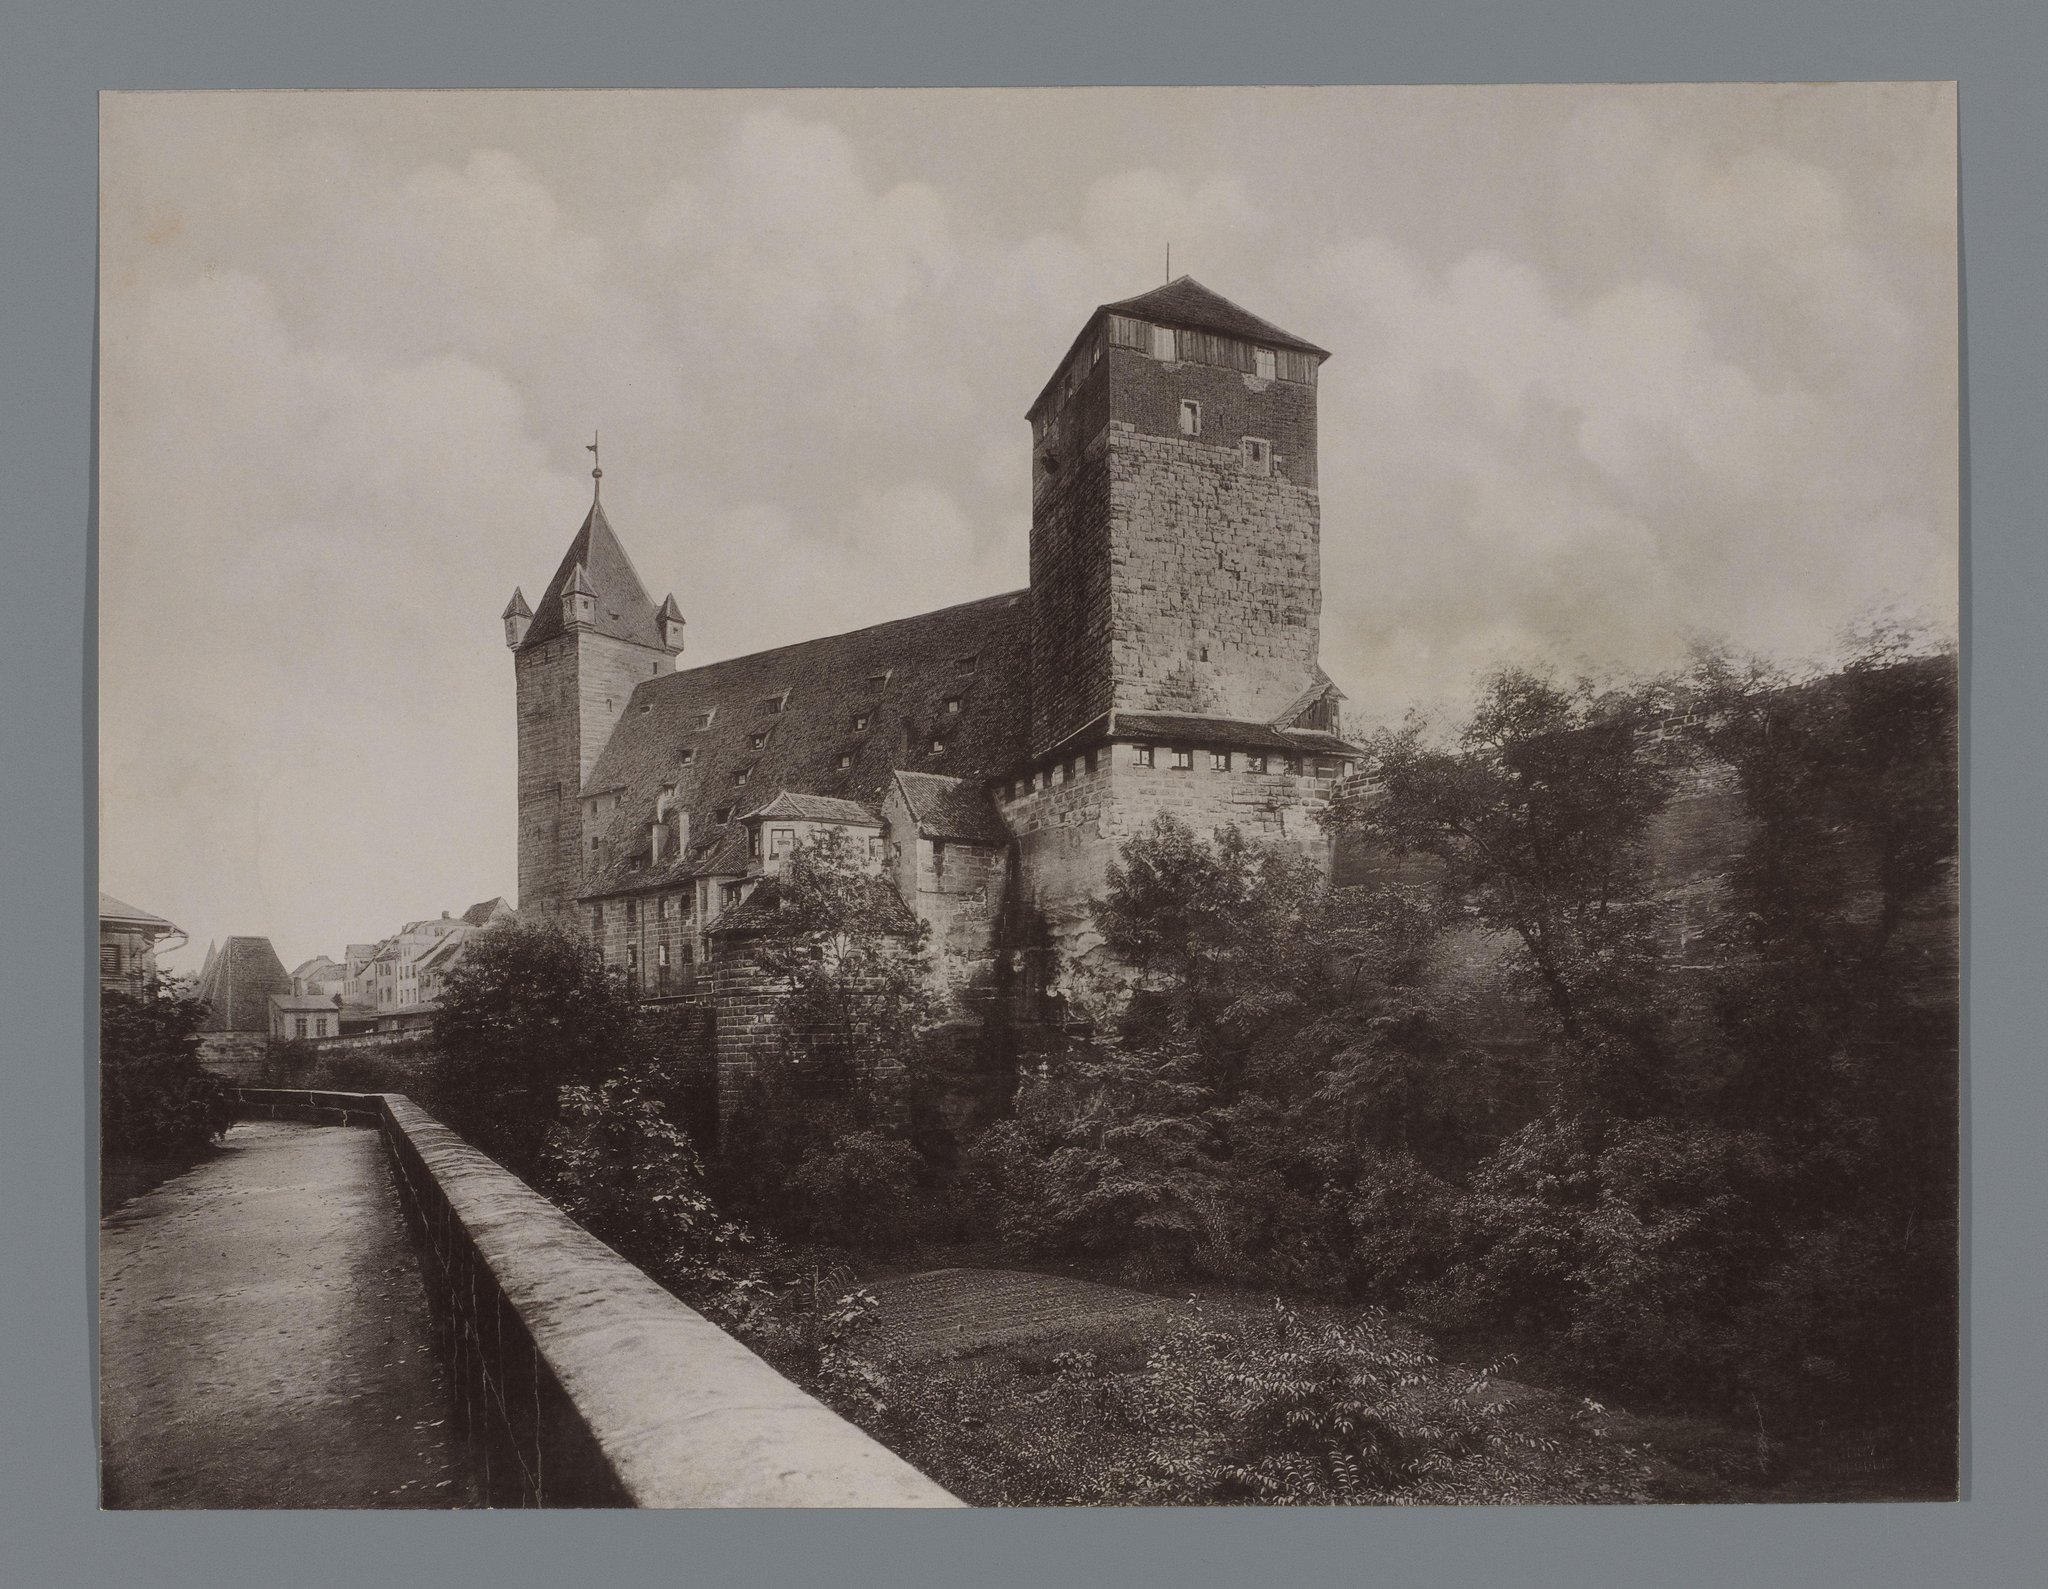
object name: photograph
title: Neurenberg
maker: Anonymous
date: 1880-1920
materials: photographic support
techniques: photograph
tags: neurenberg